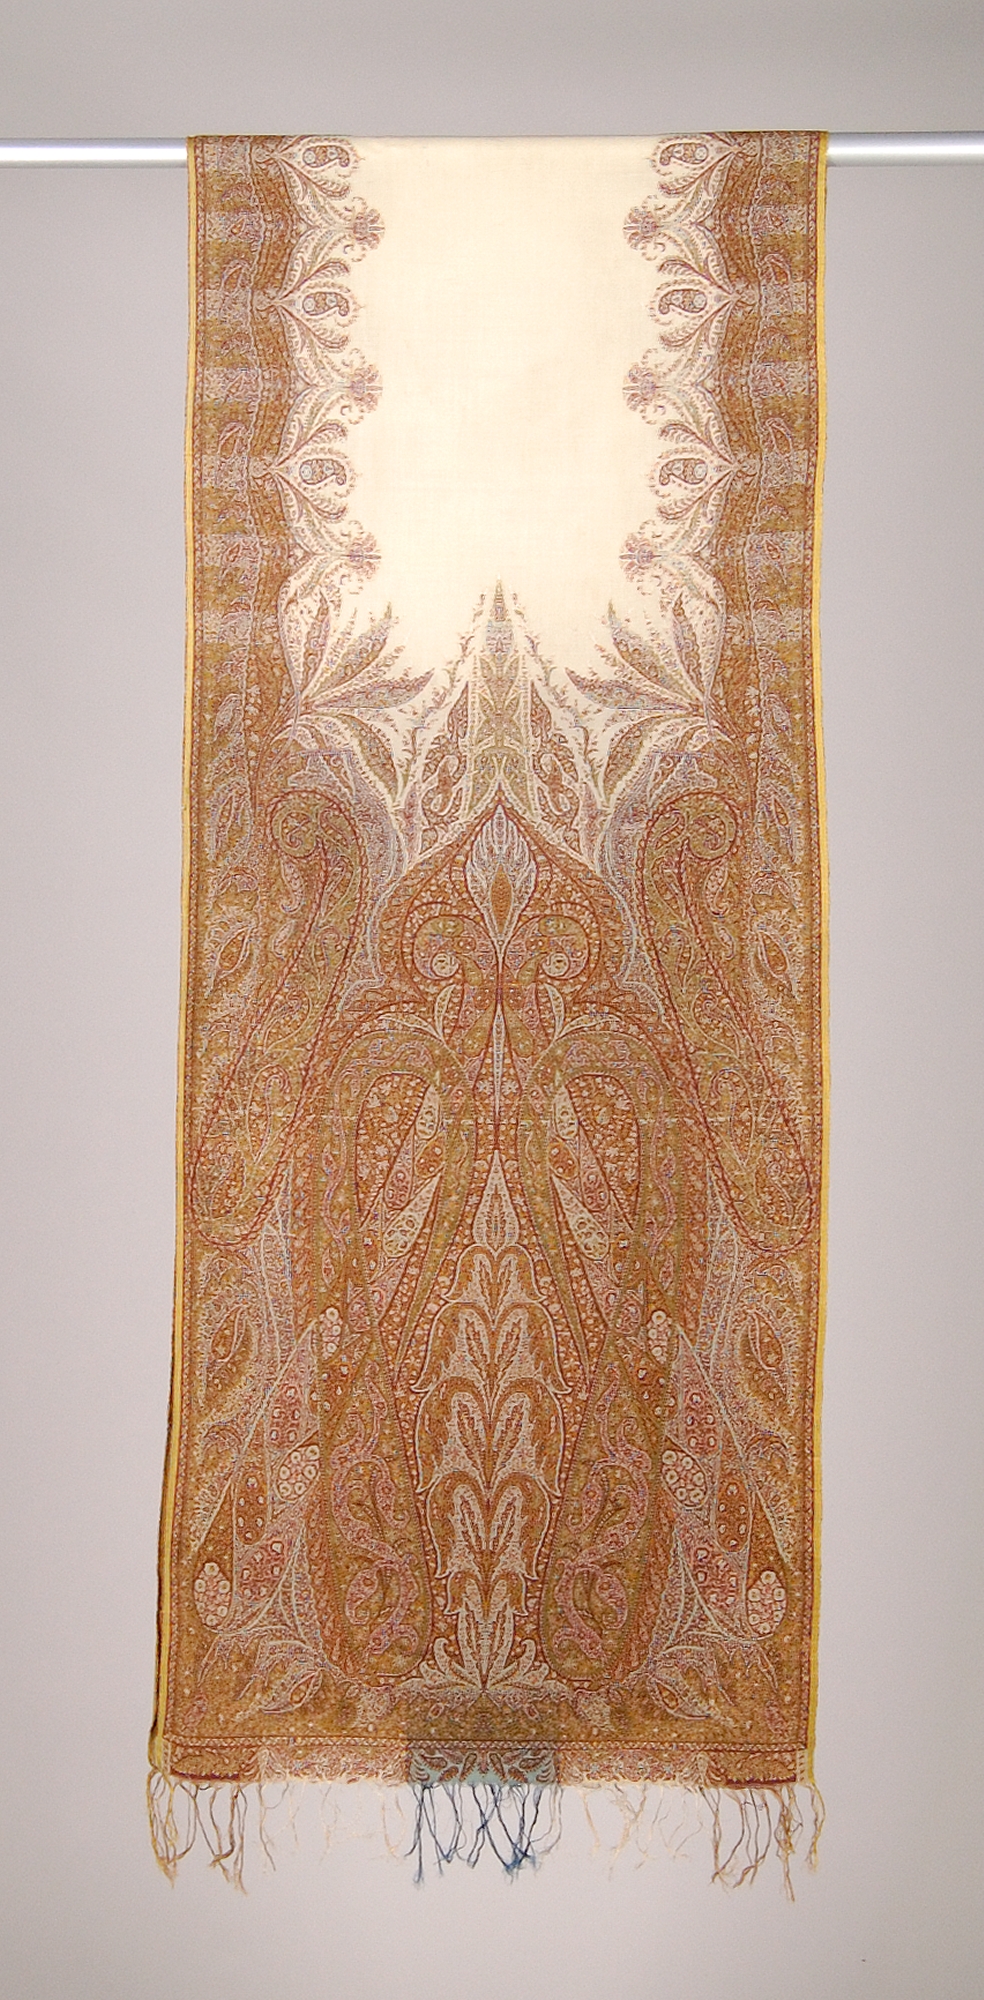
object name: stole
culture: scottish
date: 1837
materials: wool